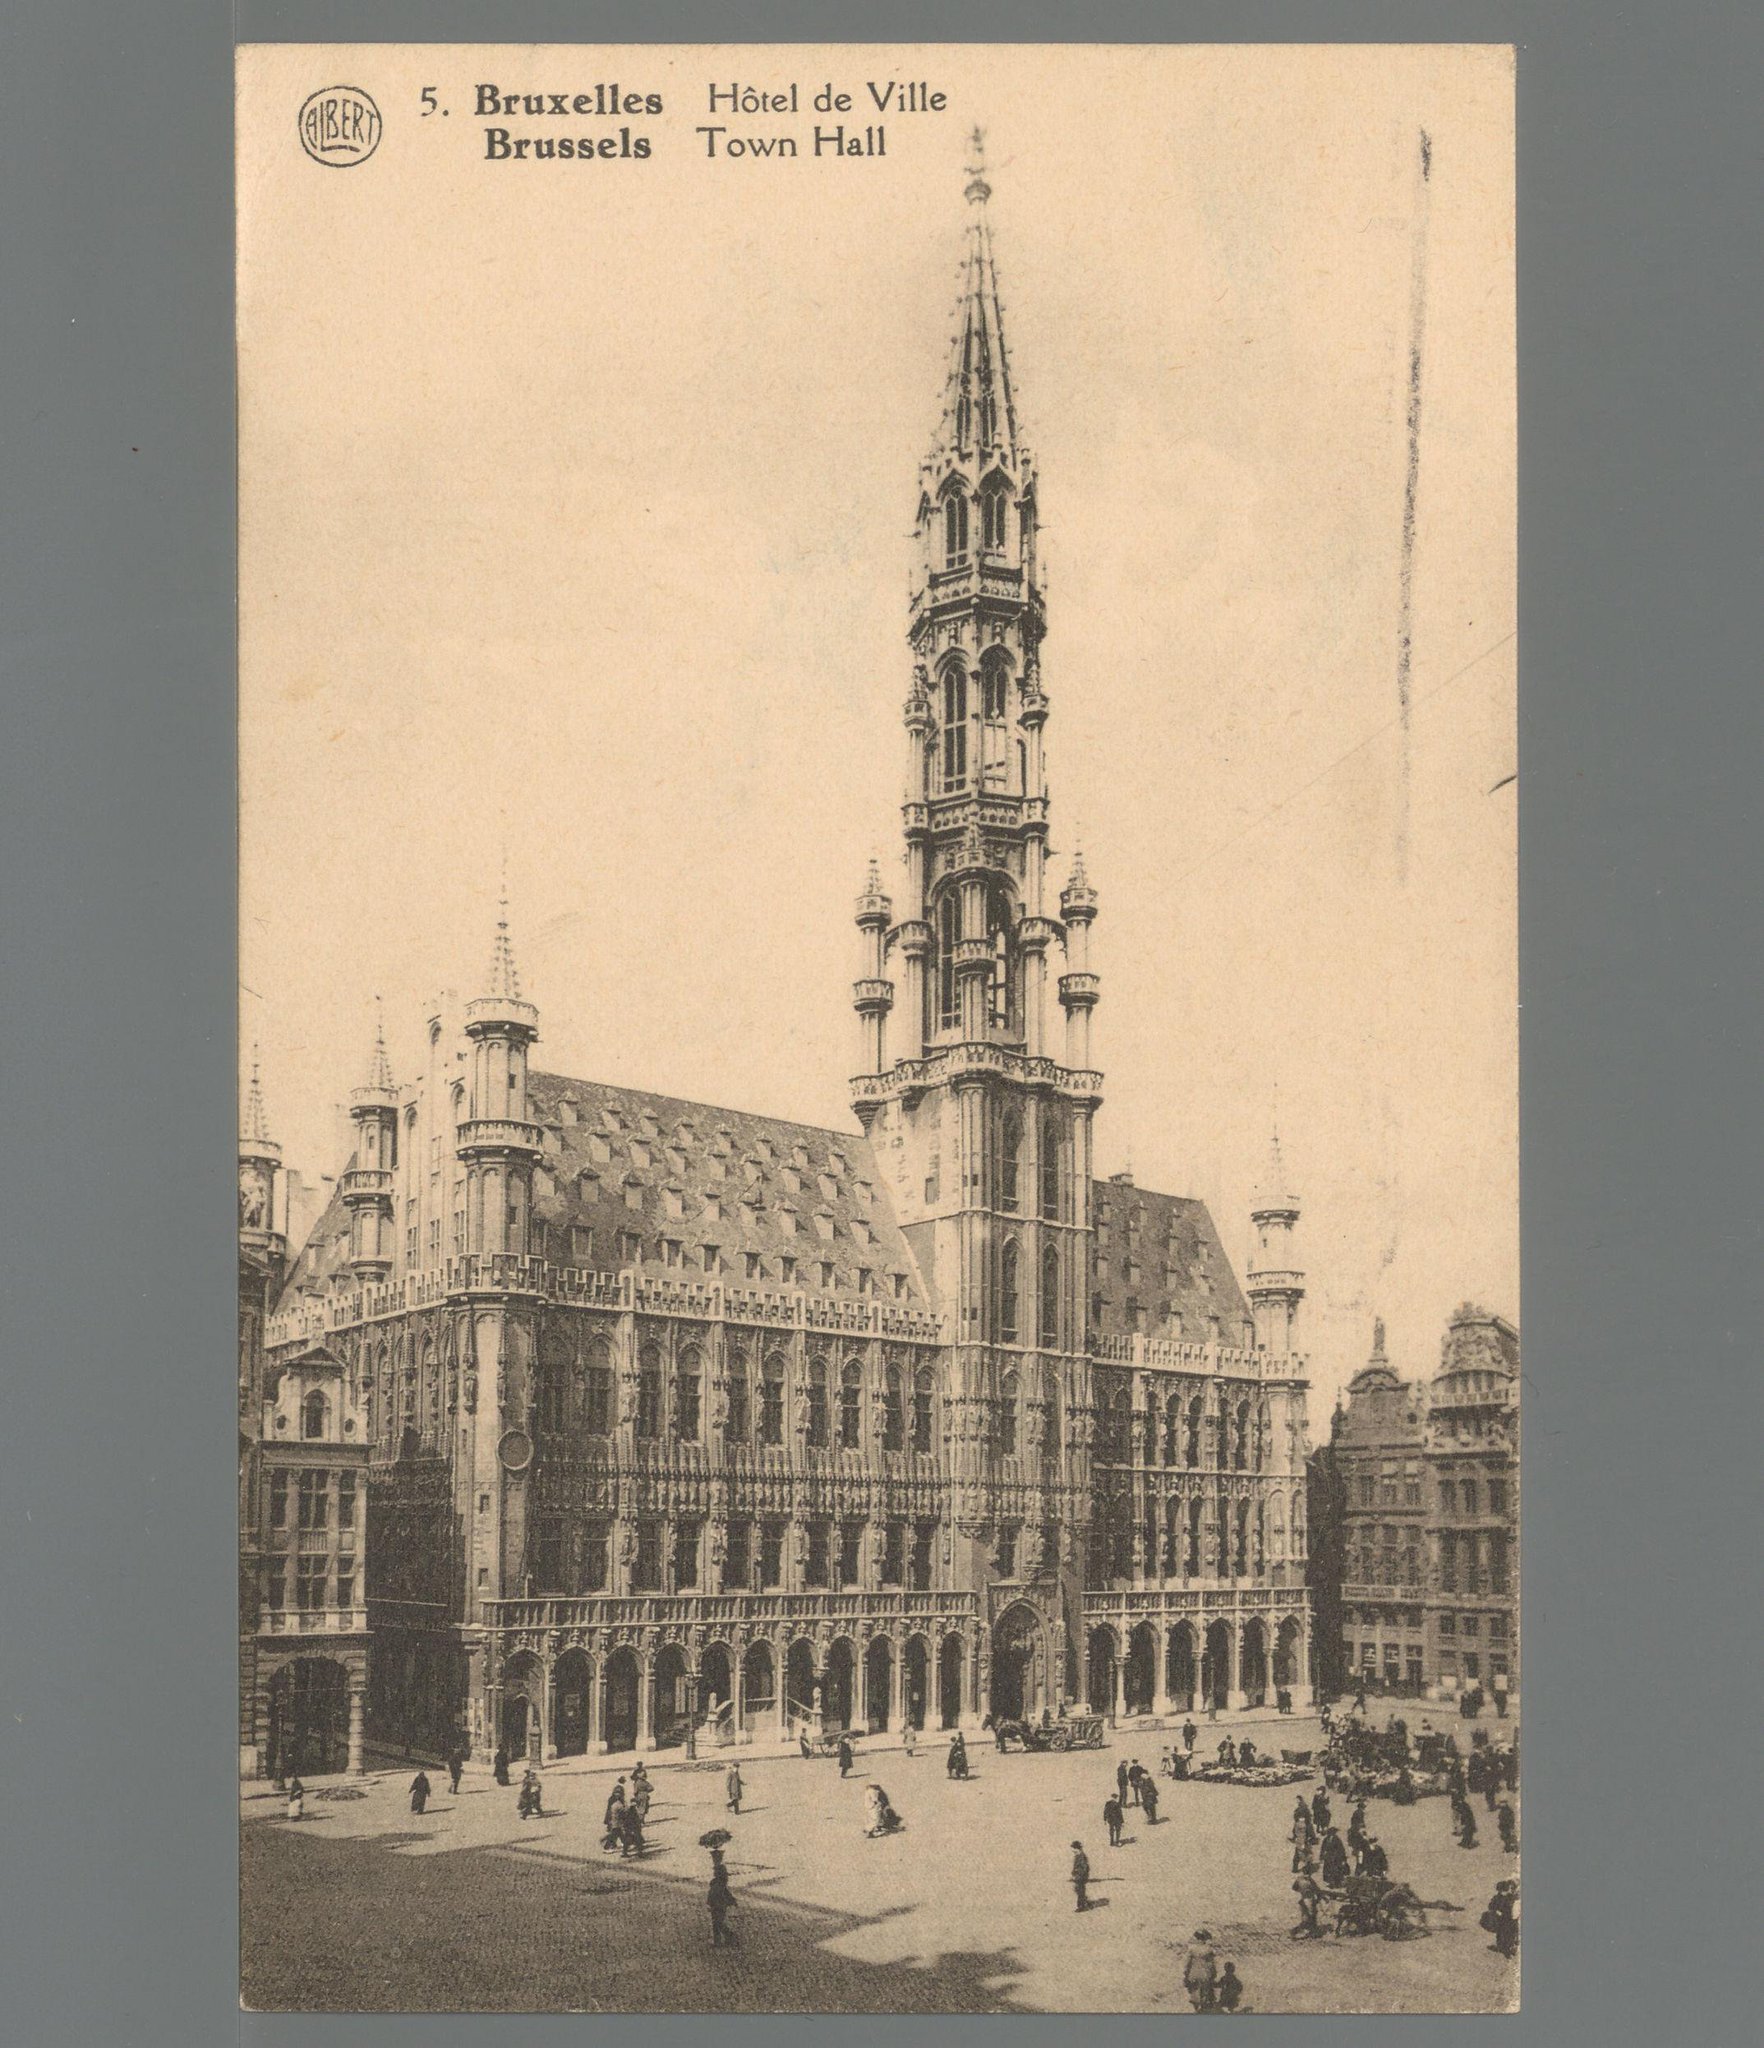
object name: photomechanical print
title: Bruxelles. Hôtel de Ville / Brussels. Town Hall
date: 1914-1928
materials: cardboard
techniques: photograph, writing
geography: brussels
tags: townhall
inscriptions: postage stamp